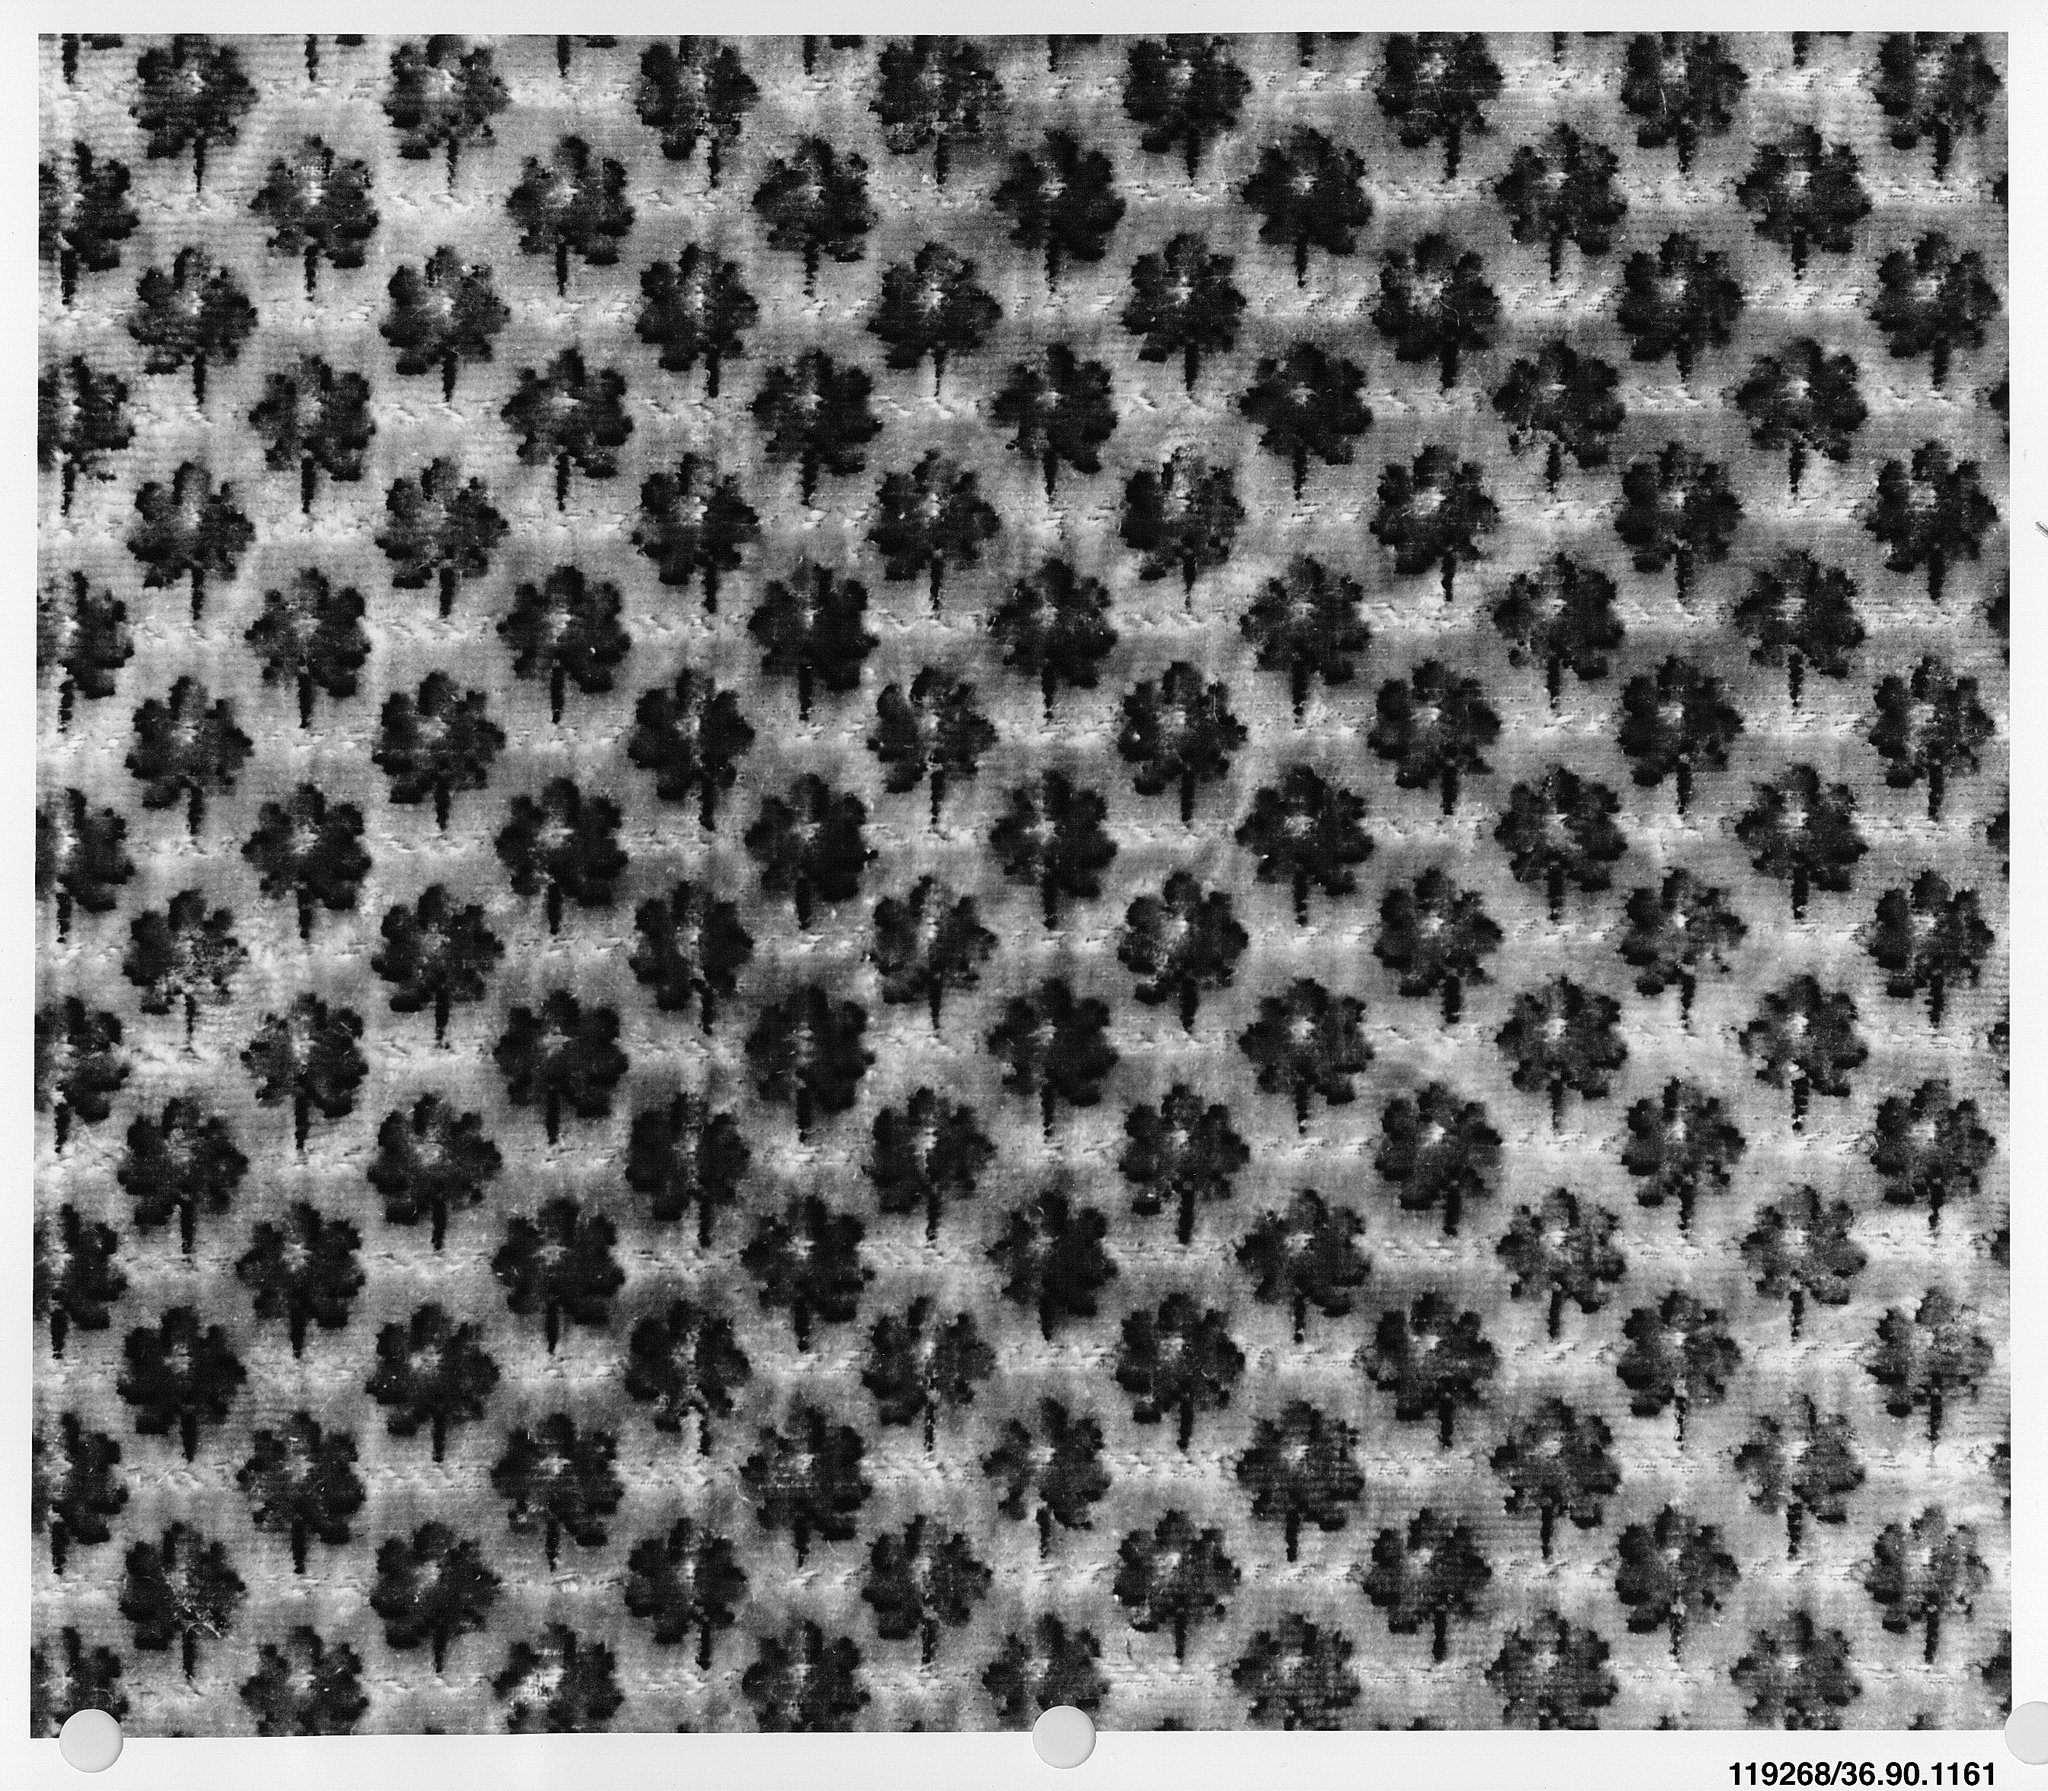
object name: piece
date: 1701-1800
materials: silk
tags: flowers